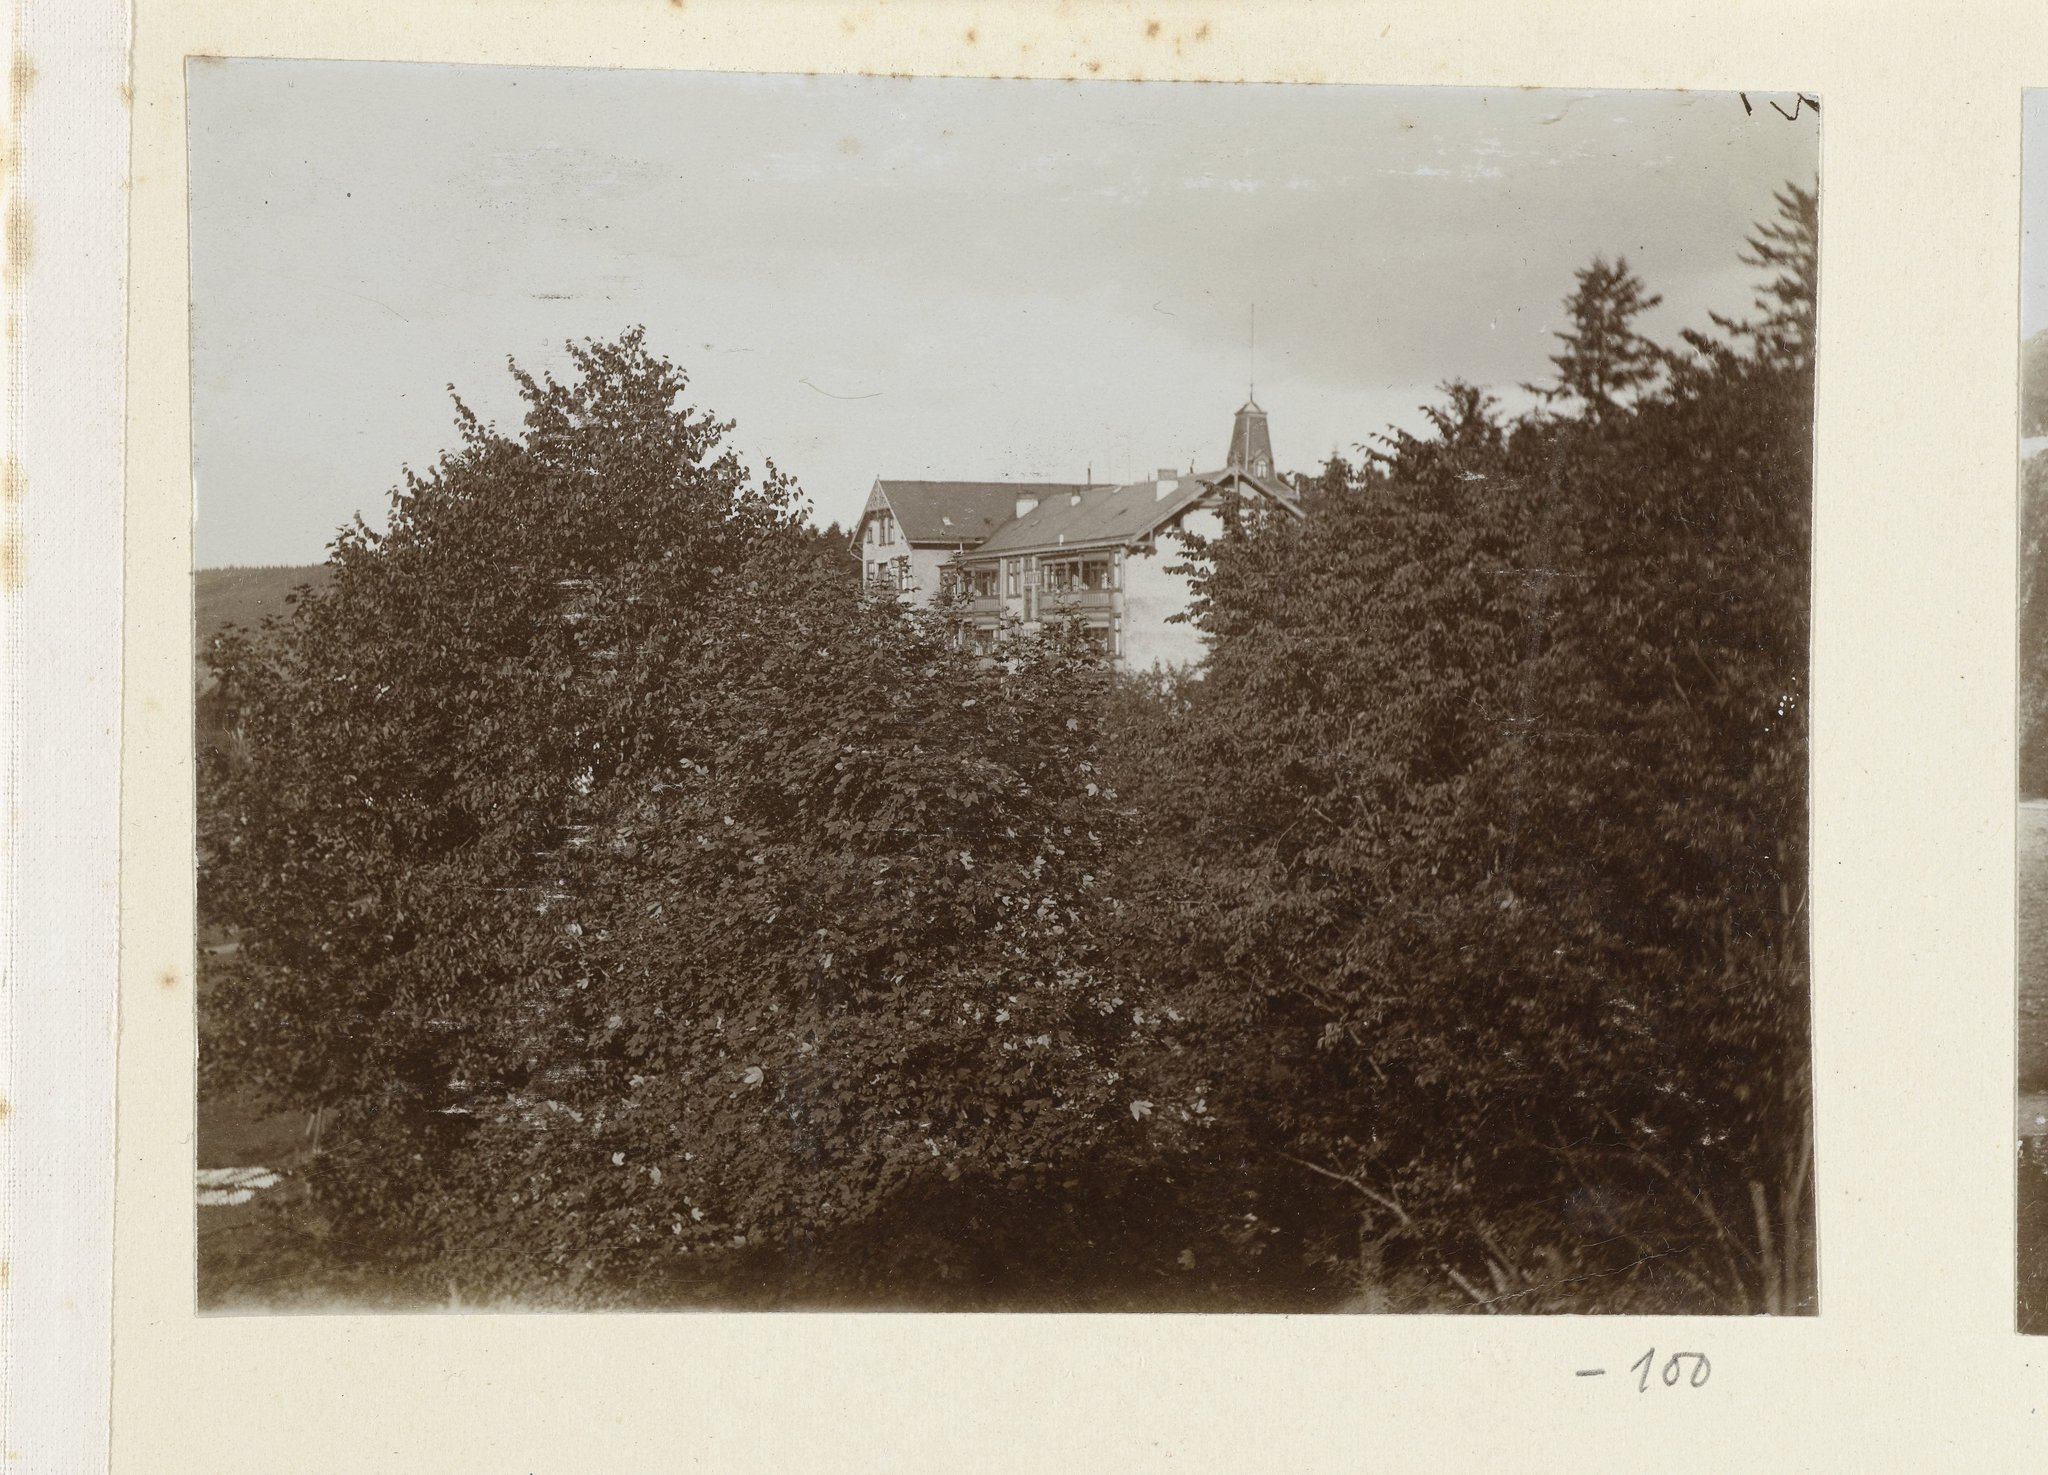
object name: photograph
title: Gezicht op een huis of hotel in de Harz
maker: geldolph adriaan kessler (dolph)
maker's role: fotograaf, industrieel, voetballer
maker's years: 1884-1945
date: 1903-1908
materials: cardboard, photographic support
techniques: gelatin silver print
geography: harz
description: Gezicht op een huis of hotel in vermoedelijk de Harz. Onderdeel van het fotoalbum van Dolph Kessler met opnamen die hij maakte tijdens zijn verblijf in Engeland en op een wereldreis die hij als secretaris van Henri Deterding (directeur Koninklijke Olie) ondernam naar Nederlands-Indië, Japan, China en de Verenigde Staten, tussen 1906 en 1908.